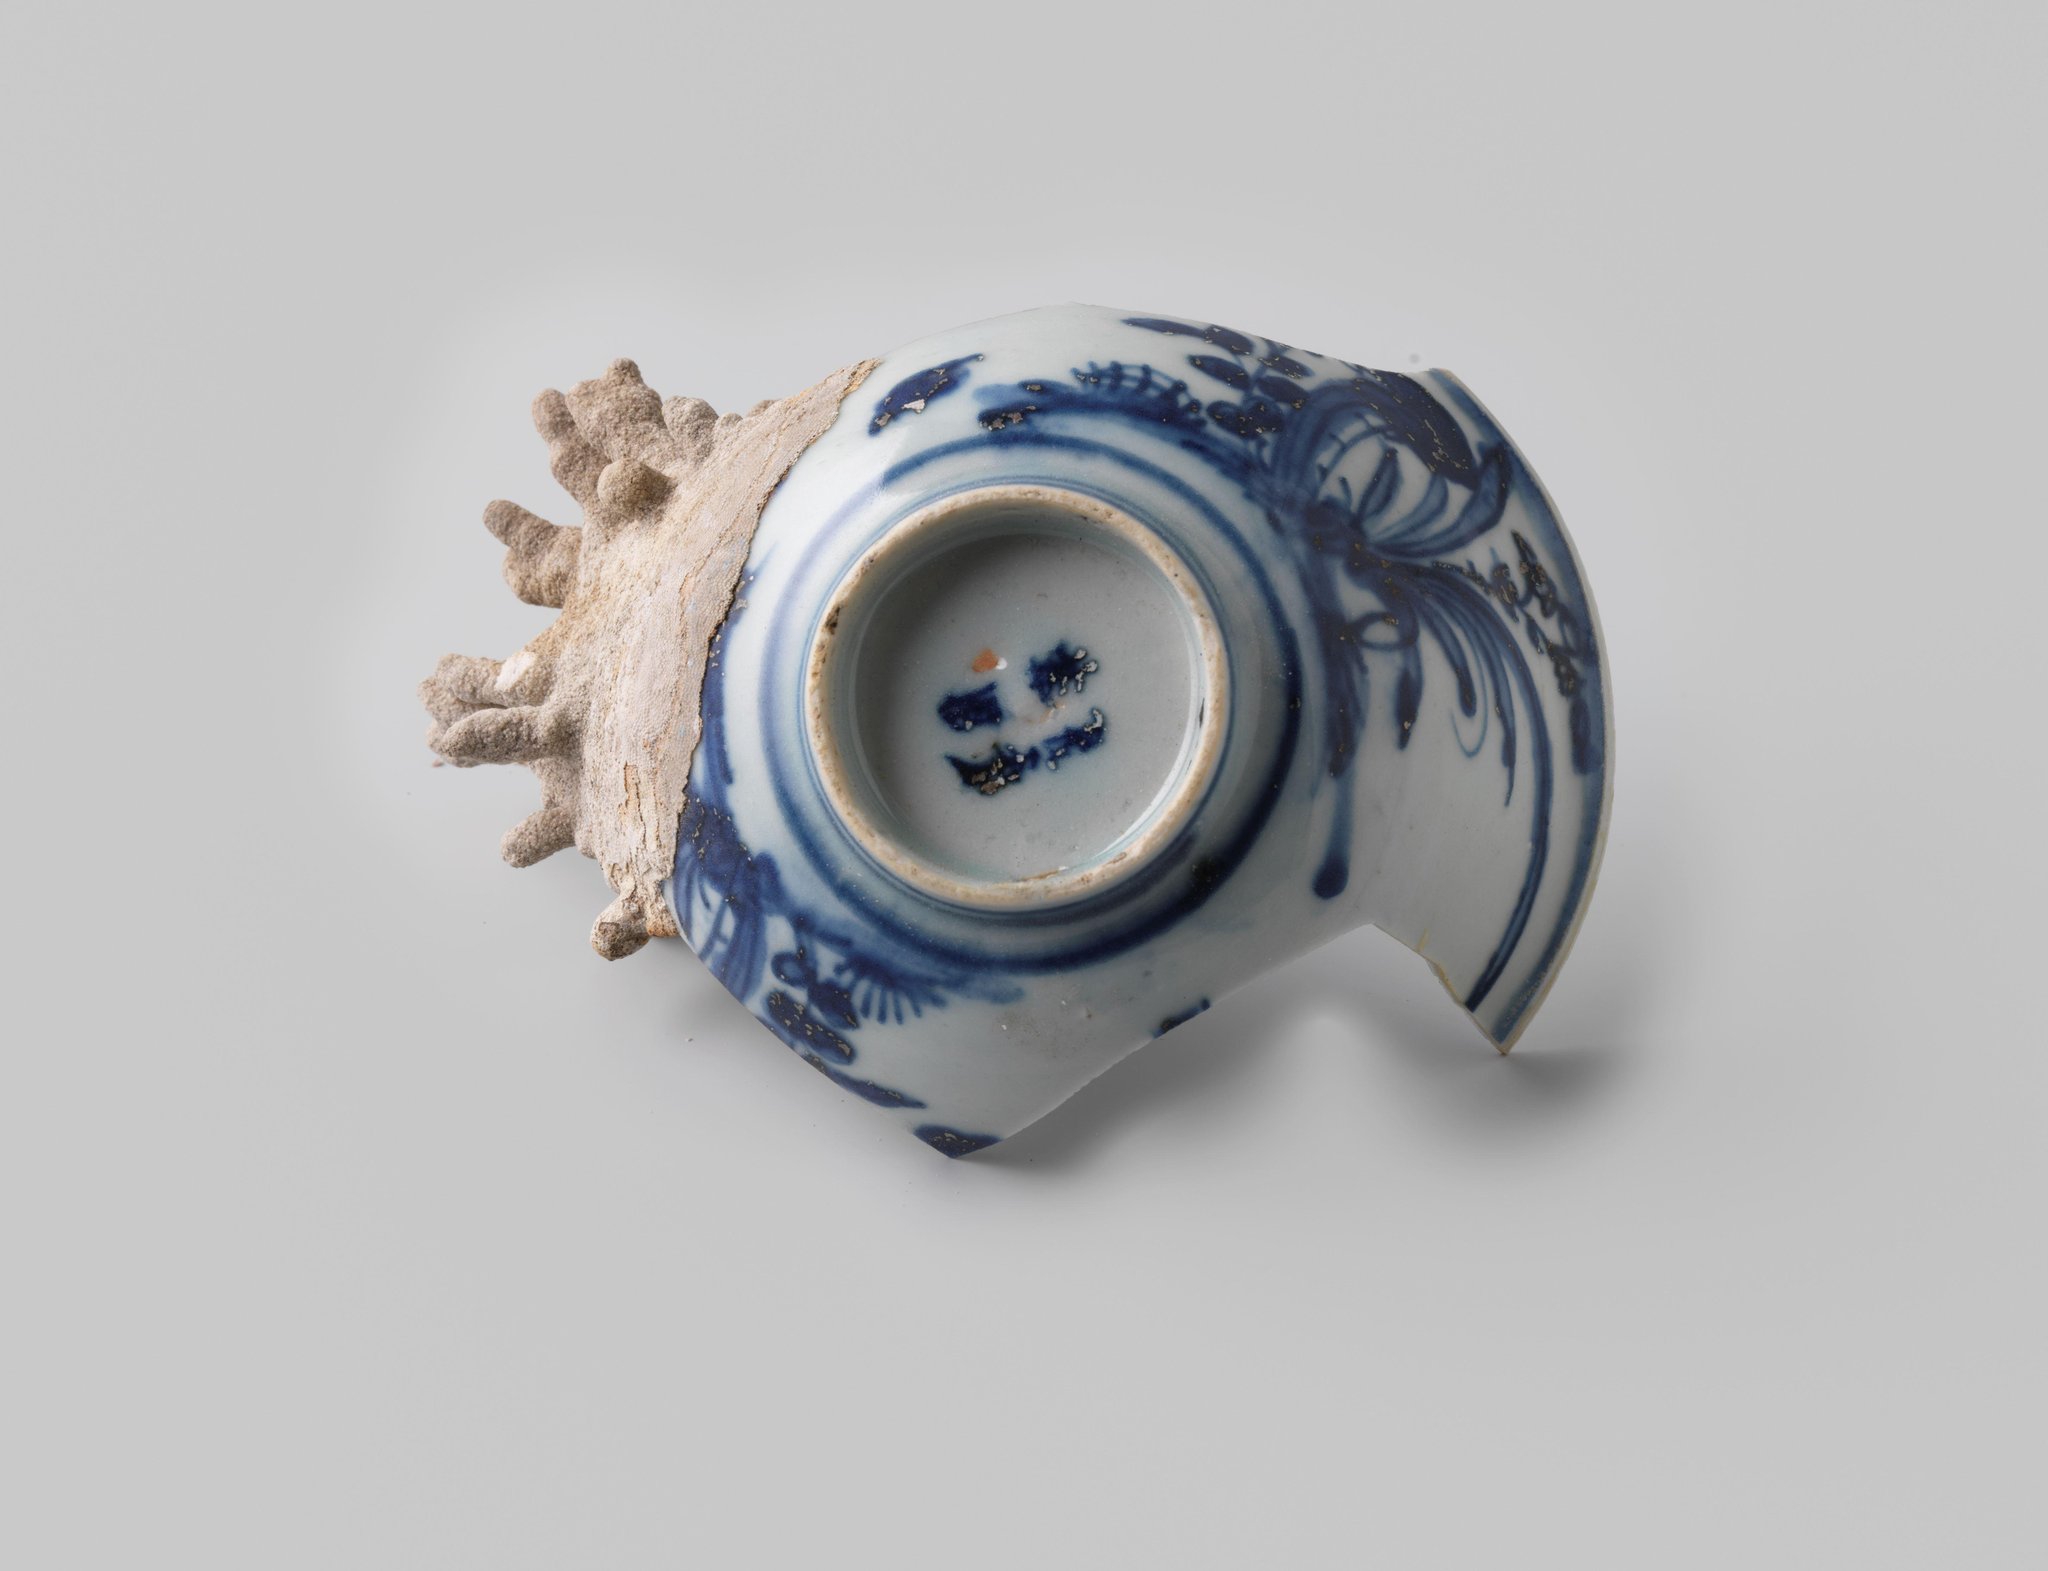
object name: sherd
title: Fragment kom uit V.O.C.-schip de 'Witte Leeuw'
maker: Anonymous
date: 1613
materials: porcelain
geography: jingdezhen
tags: verenigde oostindische compagnie, sint-helena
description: A bowl with encrustation. The bottom is glazed with spiral marks visible. A six-character mark, hand-written in underglaze blue: ta ming jiajing.